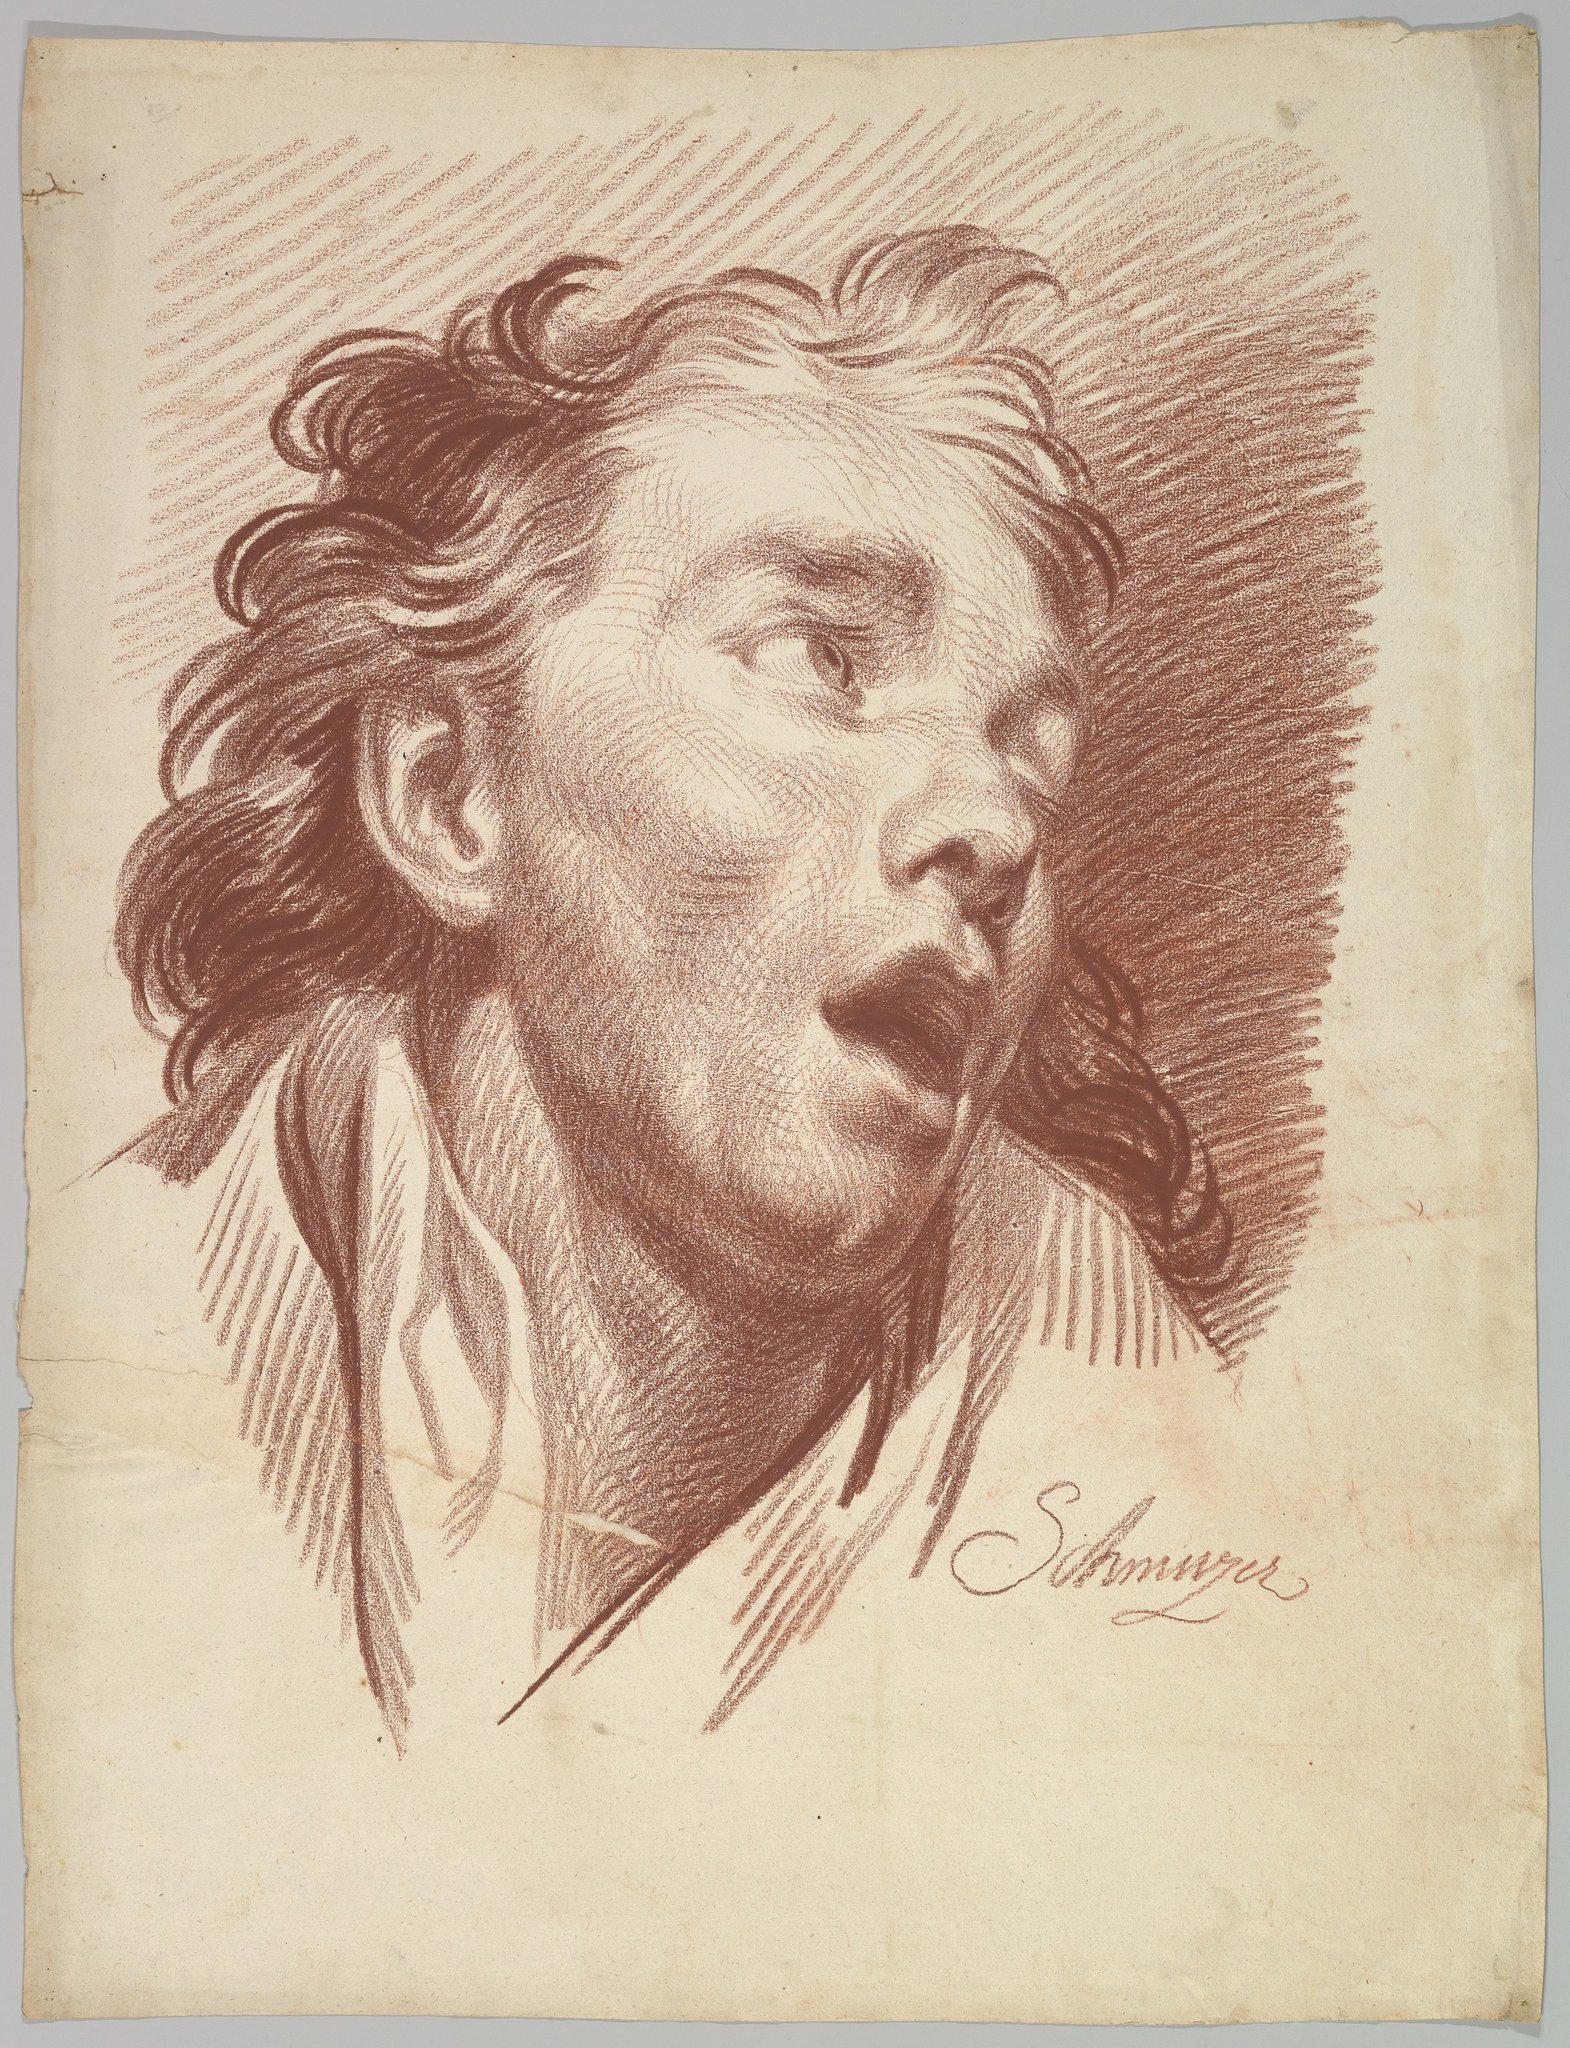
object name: drawing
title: Head of a Youth with Open Mouth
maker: jakob matthias schmutzer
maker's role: artist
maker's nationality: austrian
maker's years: 1733-1811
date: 1765-1810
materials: chalk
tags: men